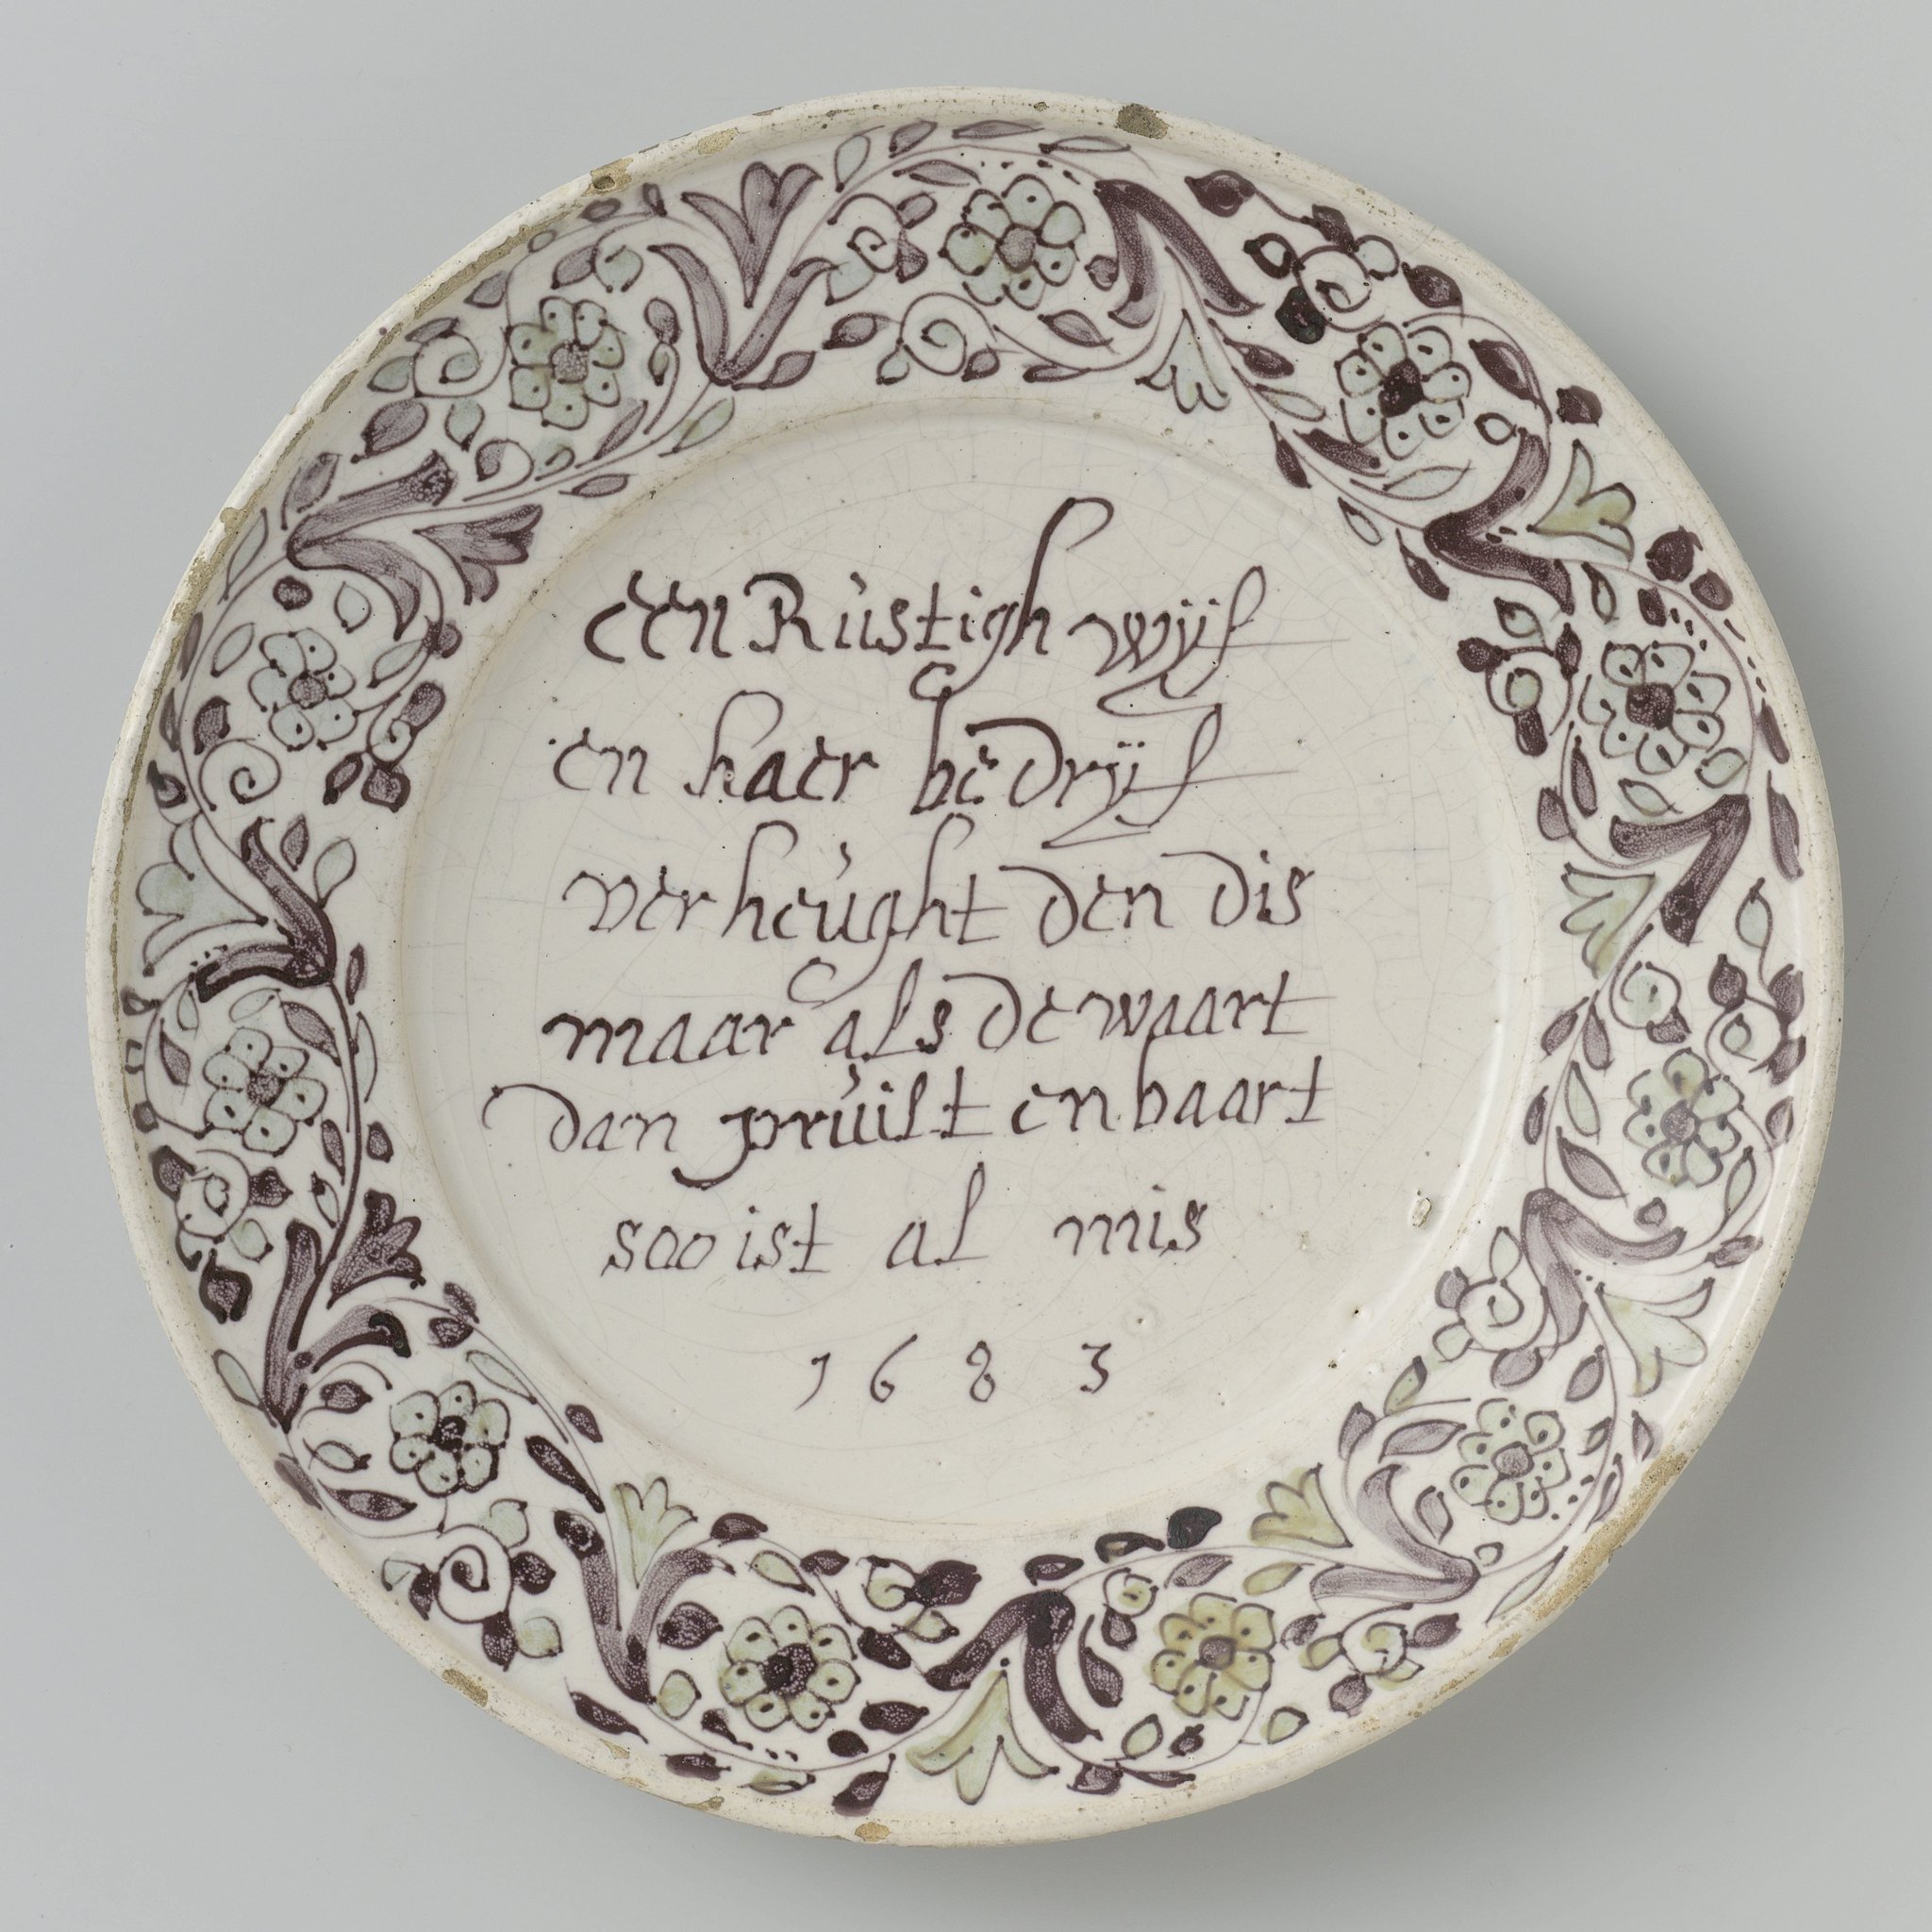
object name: plate dish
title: Bord met het opschrift: Een Rustigh wijf/ en haer bedrief/ verheught den dis/ maar als de waart/ dan pruilt en baart/ soo is al mis/ 1683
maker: Anonymous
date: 1683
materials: faience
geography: delft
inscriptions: inscription: ‘Een Rustigh wijf/ en haer bedrief/ verheught den dis/ maar als de waart // dan pruilt en baart/ soo is al mis’, date: ‘1683’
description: Bord van faience. Veelkleurig beschilderd met een tekst. Een Rustigh wijf/ en haer bedrief/ verheught den dis/ maar als de waart // dan pruilt en baart/ soo is al mis/ 1683.